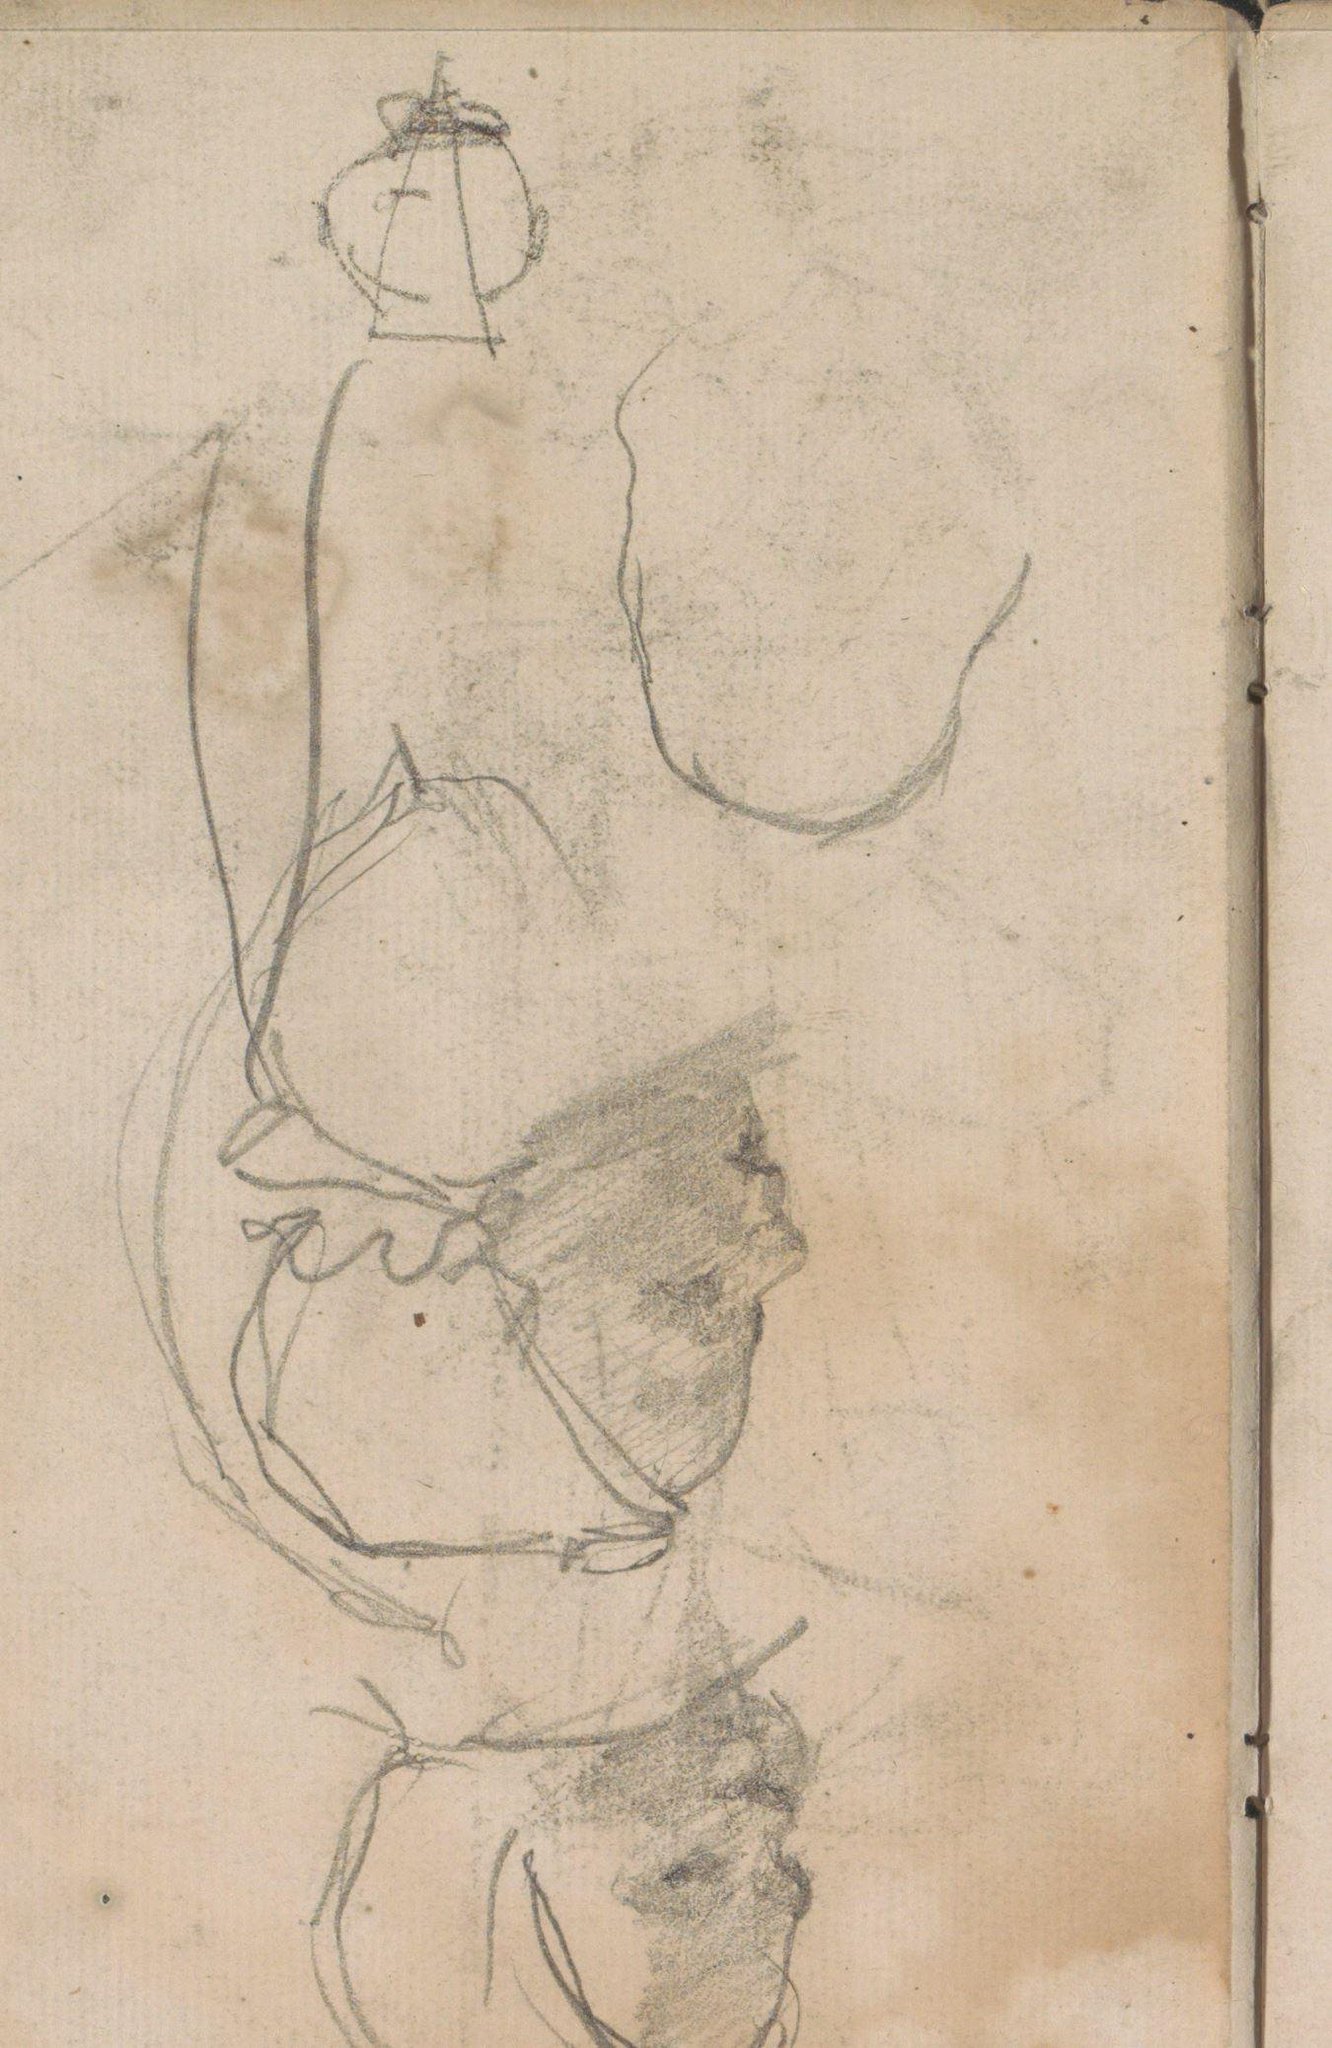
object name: sketchbook leaf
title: Twee studies van een baby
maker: george hendrik breitner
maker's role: draughtsman, painter, print maker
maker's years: 1857-1923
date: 1880-1882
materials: paper, pencil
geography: the hague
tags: infant, baby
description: Pagina 19 uit een schetsboek met 29 bladen.